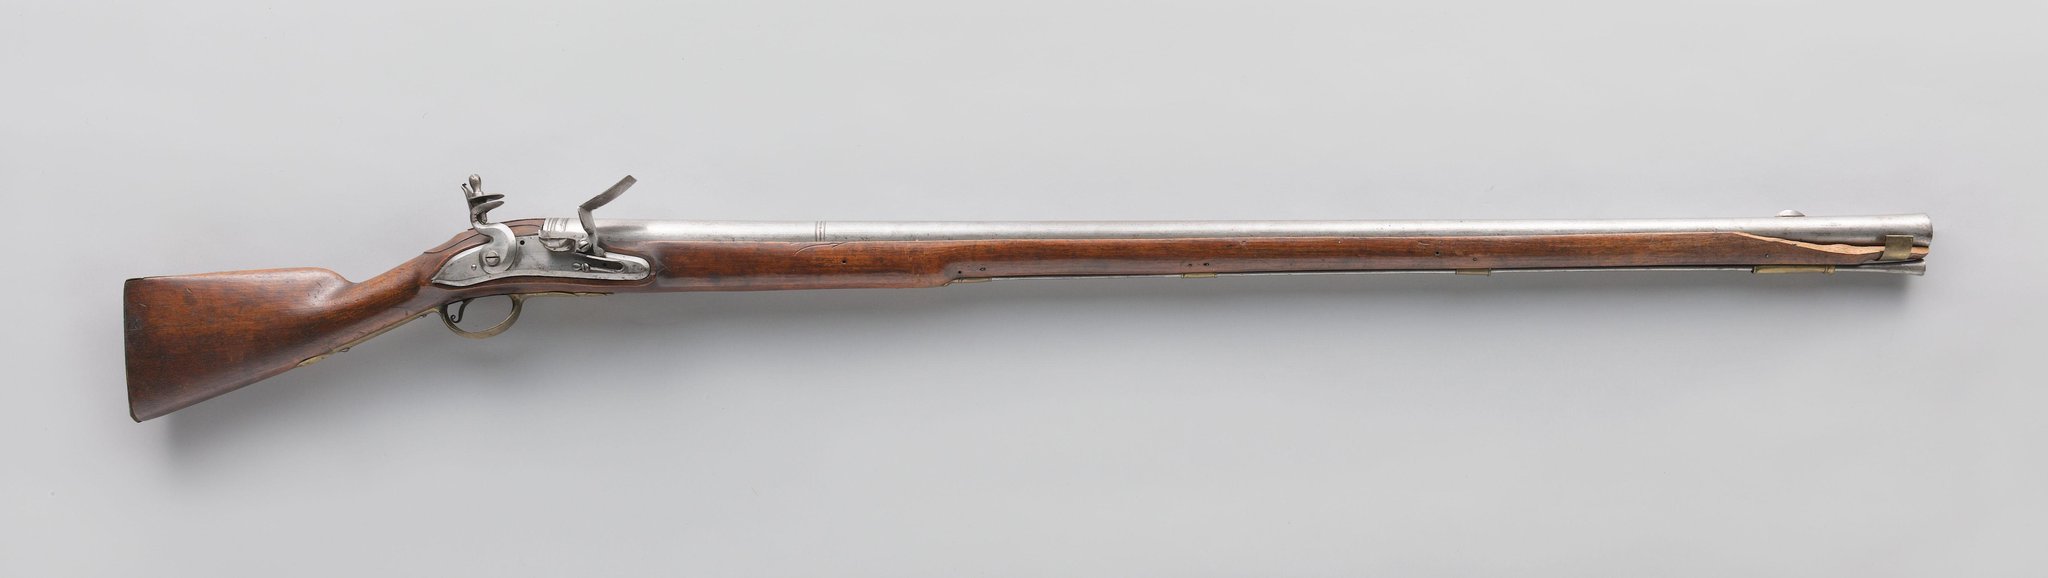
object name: flintlock pistol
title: Flintlock Wall Piece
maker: Anonymous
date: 1825-1840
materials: brass, iron, wood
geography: europe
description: Vestinggeweer of vuursteen walbus, voorlader. De loop wordt niet met beugels aan de lade vastgehouden, maar heeft een klein oog onderop, waar doorheen pennen gestoken worden, die tevens dwars door de lade gaan. Het geweer heeft een ijzeren laadstok.